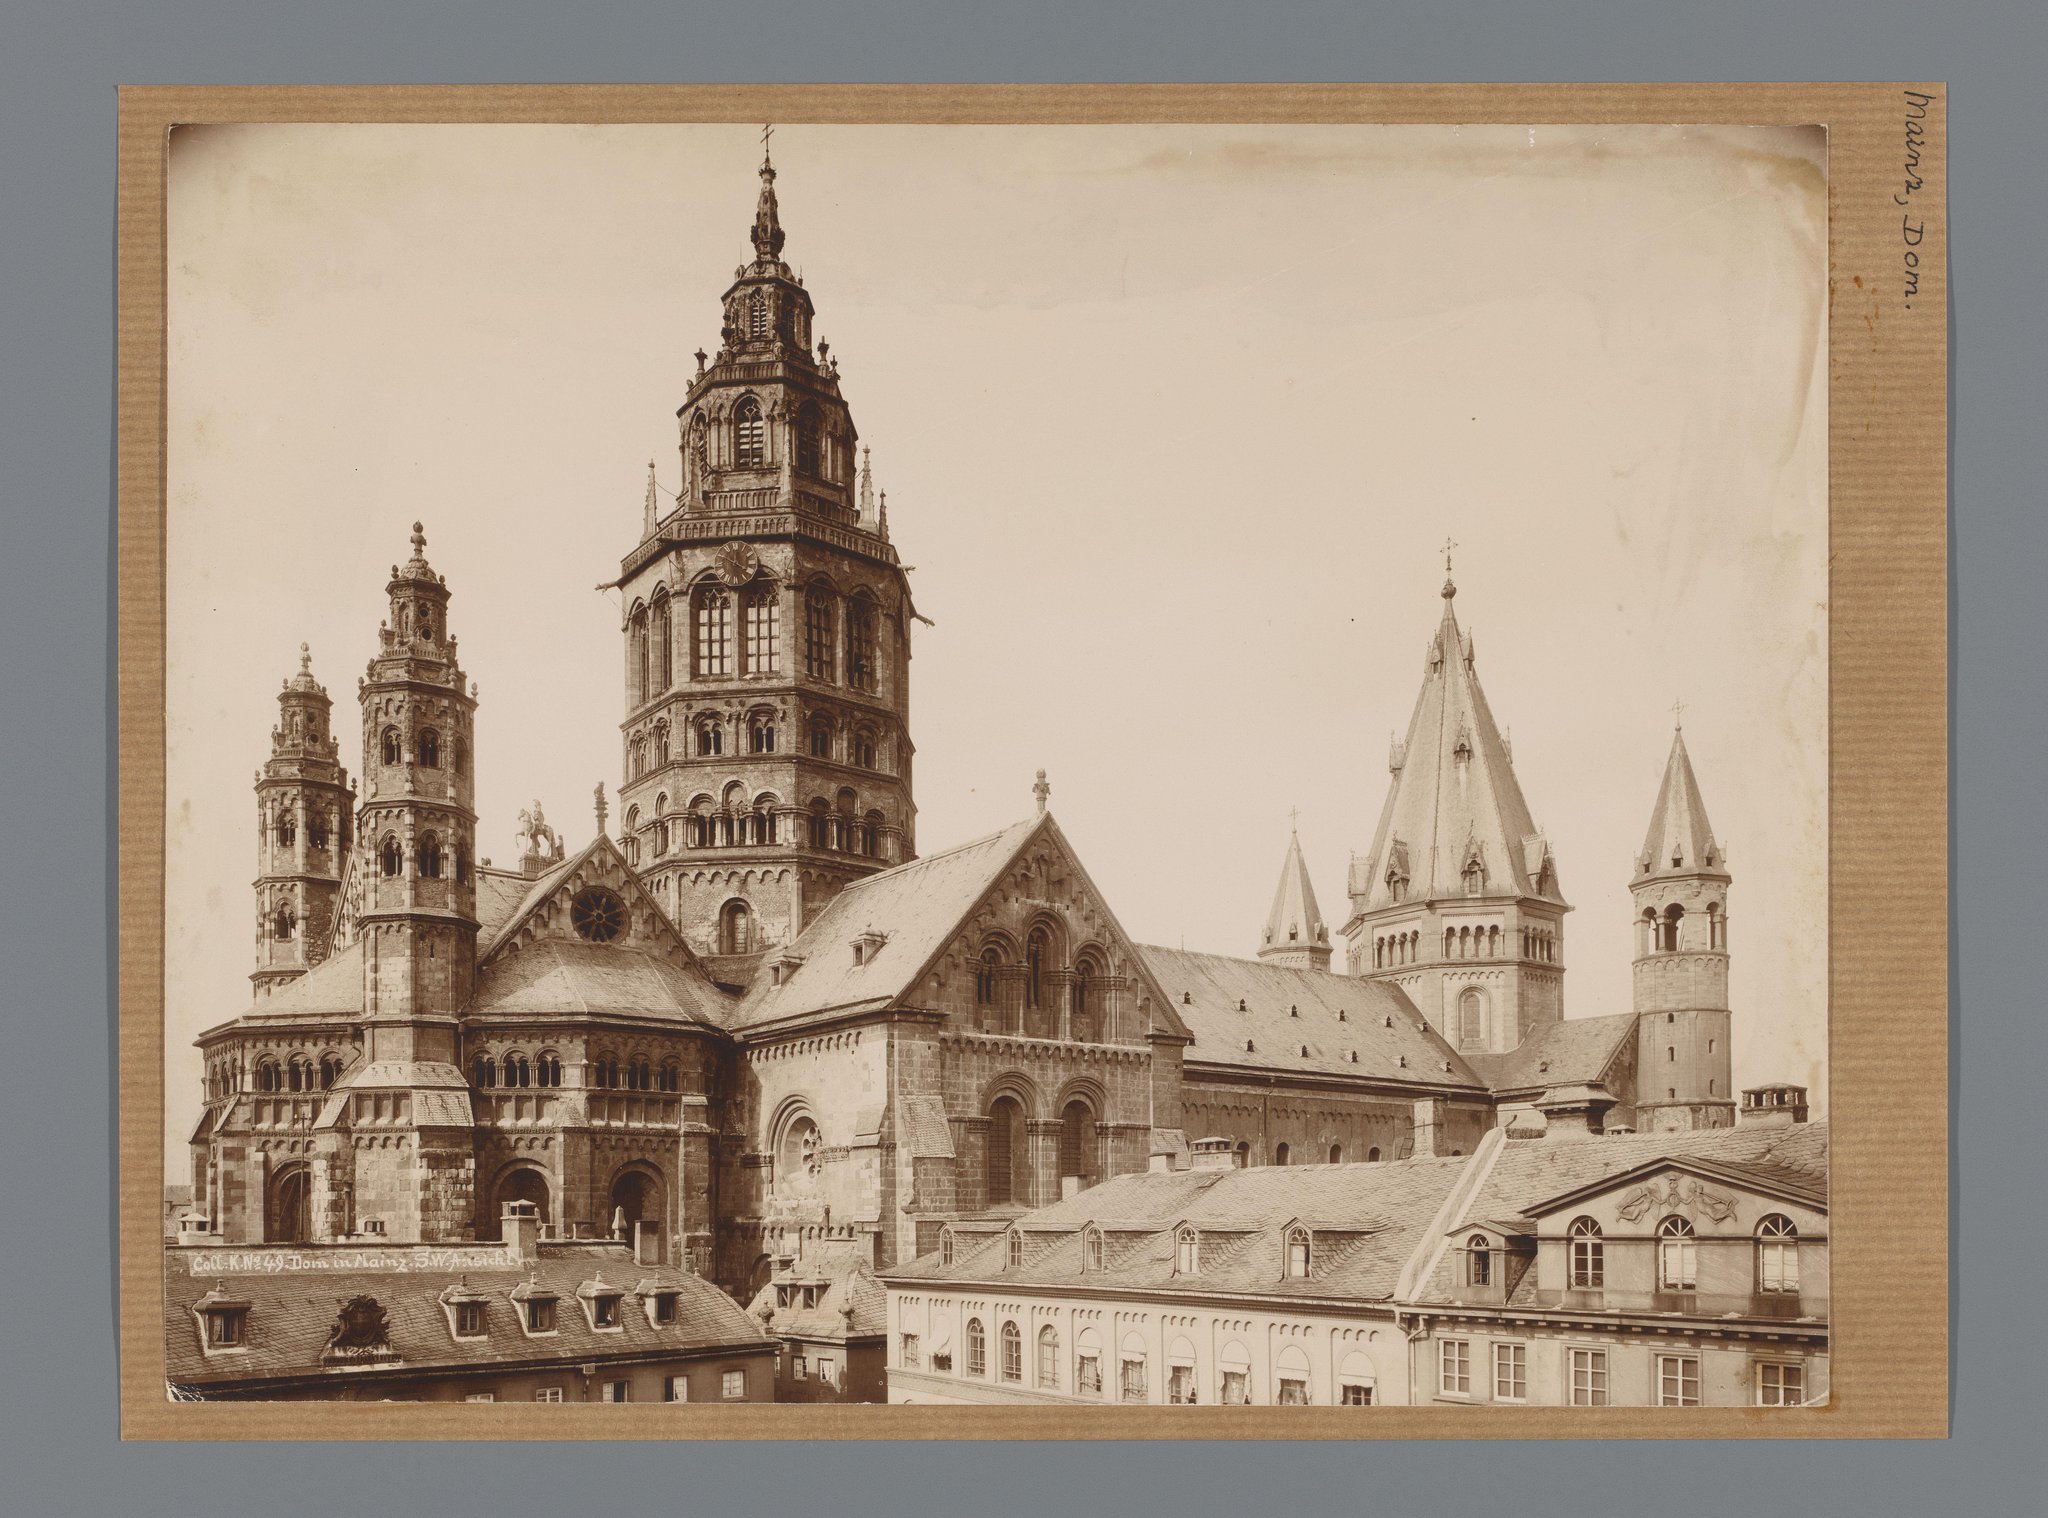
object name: photograph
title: Mainz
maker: Anonymous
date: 1870-1900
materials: photographic support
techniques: collodion silver print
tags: mainz